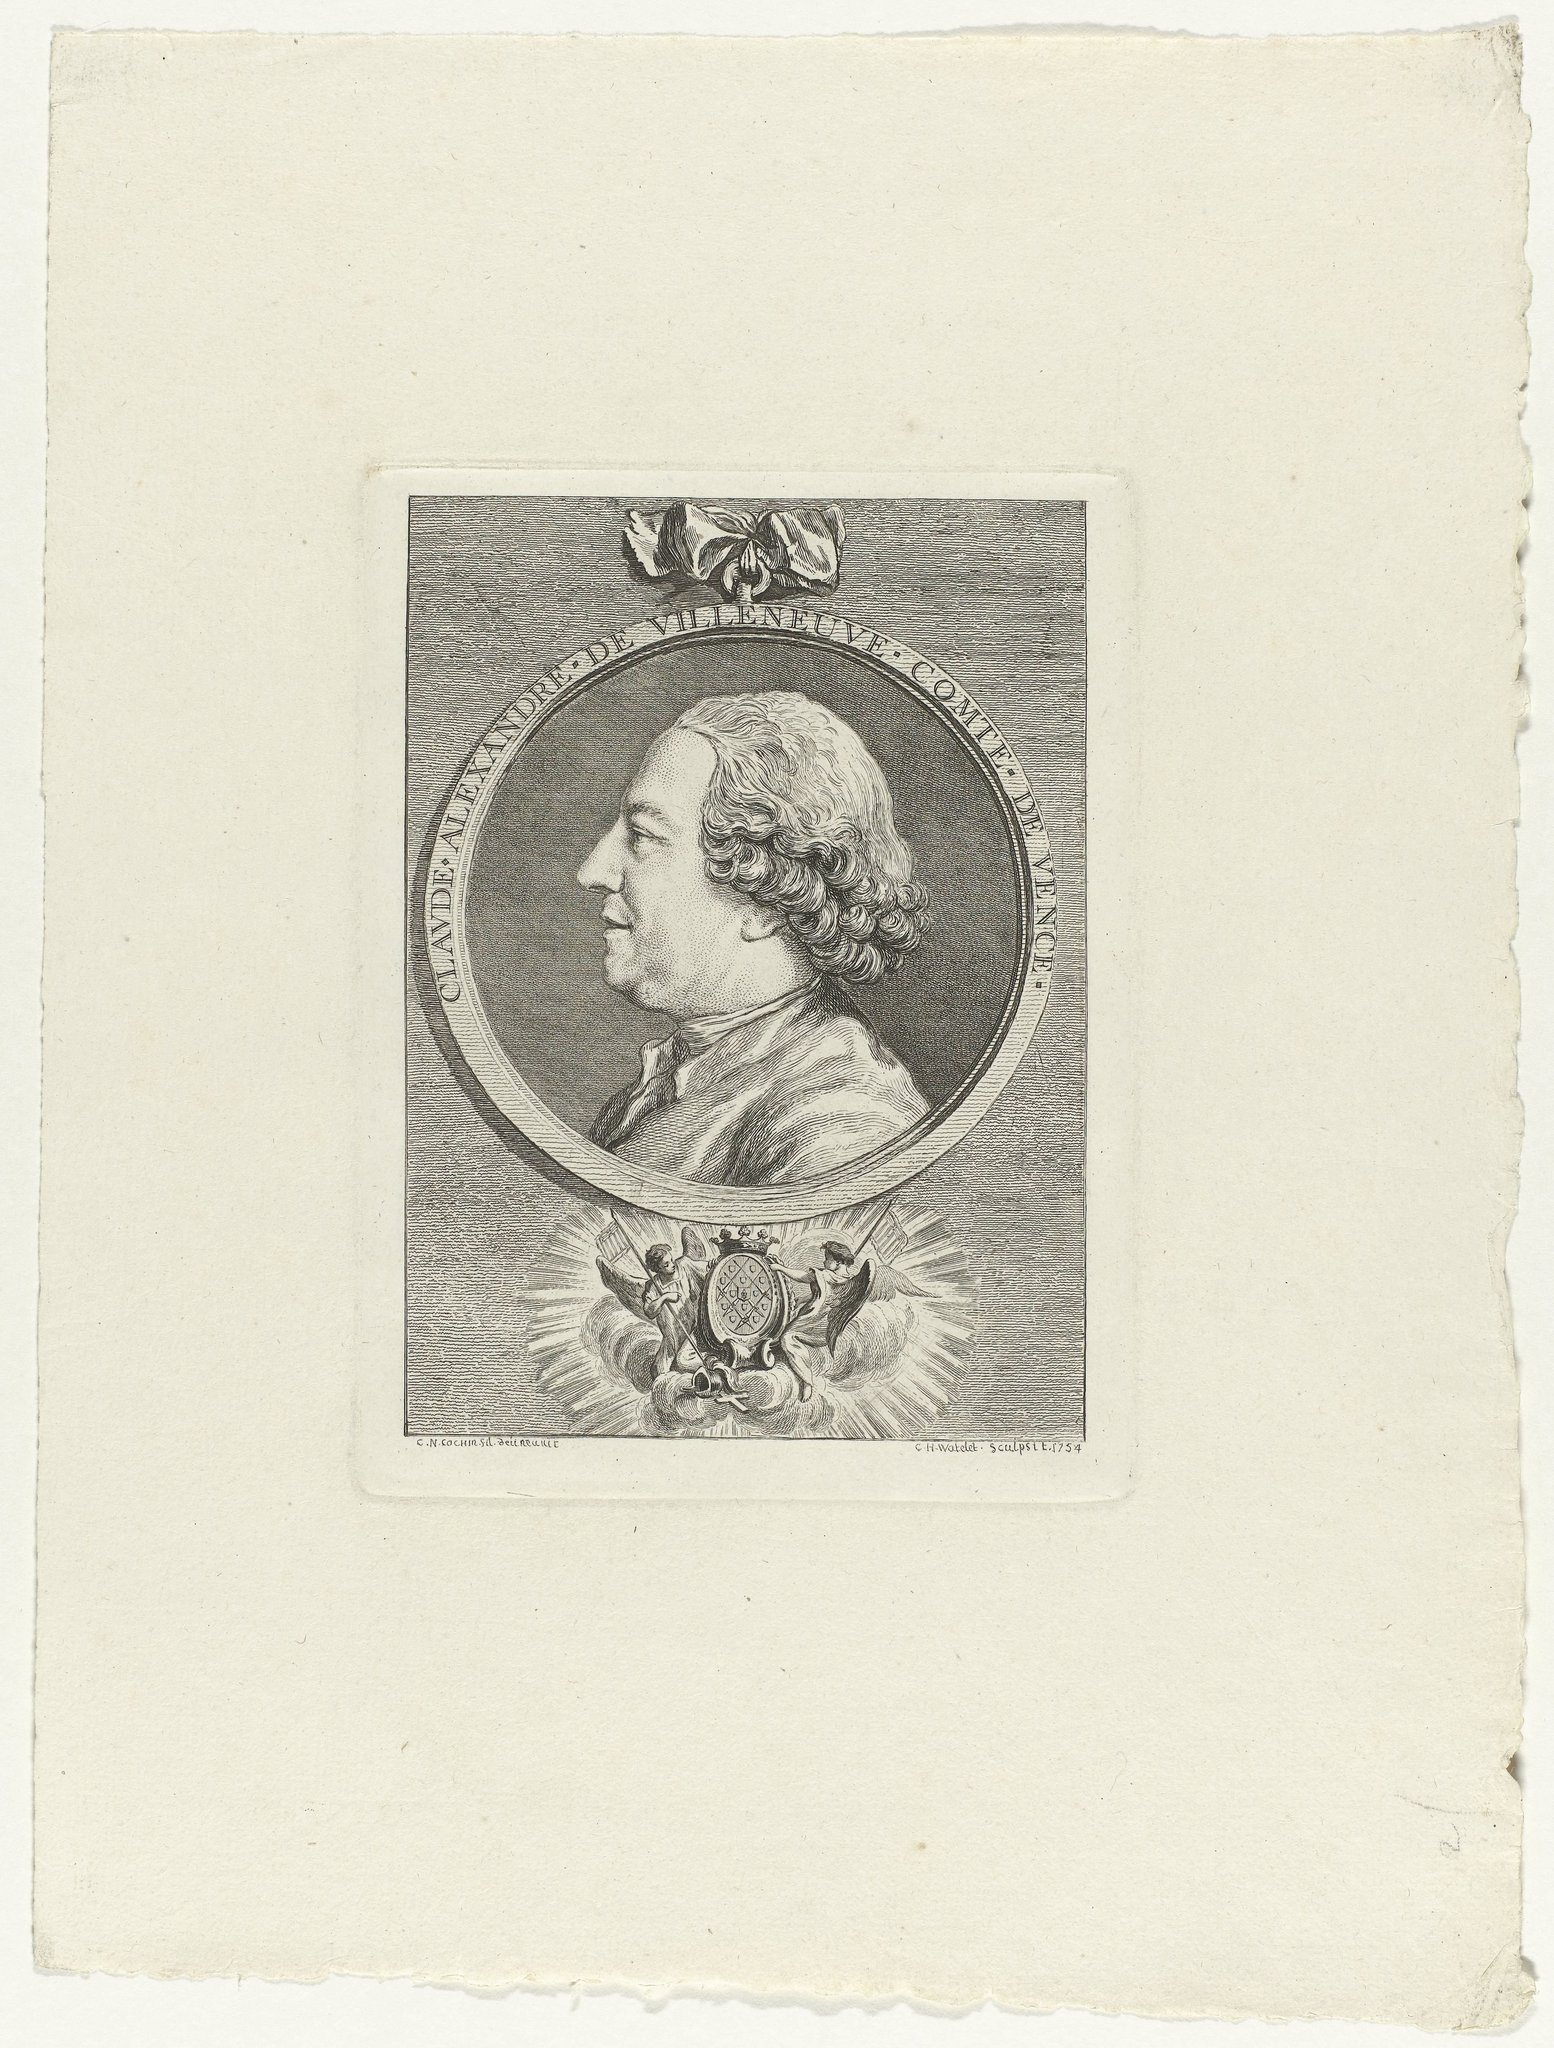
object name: print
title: Portret van Claude Alexandre de Villeneuve, Comte de Vence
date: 1754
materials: paper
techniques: etching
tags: claude-alexander de villeneuve (comte de vence), historical persons, adult man (+ sideview, profile)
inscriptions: collector's mark: Lugt 2228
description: Buste naar links, in ronde lijst met strik midden boven. Midden onder zijn wapen, vastgehouden door twee engelen.